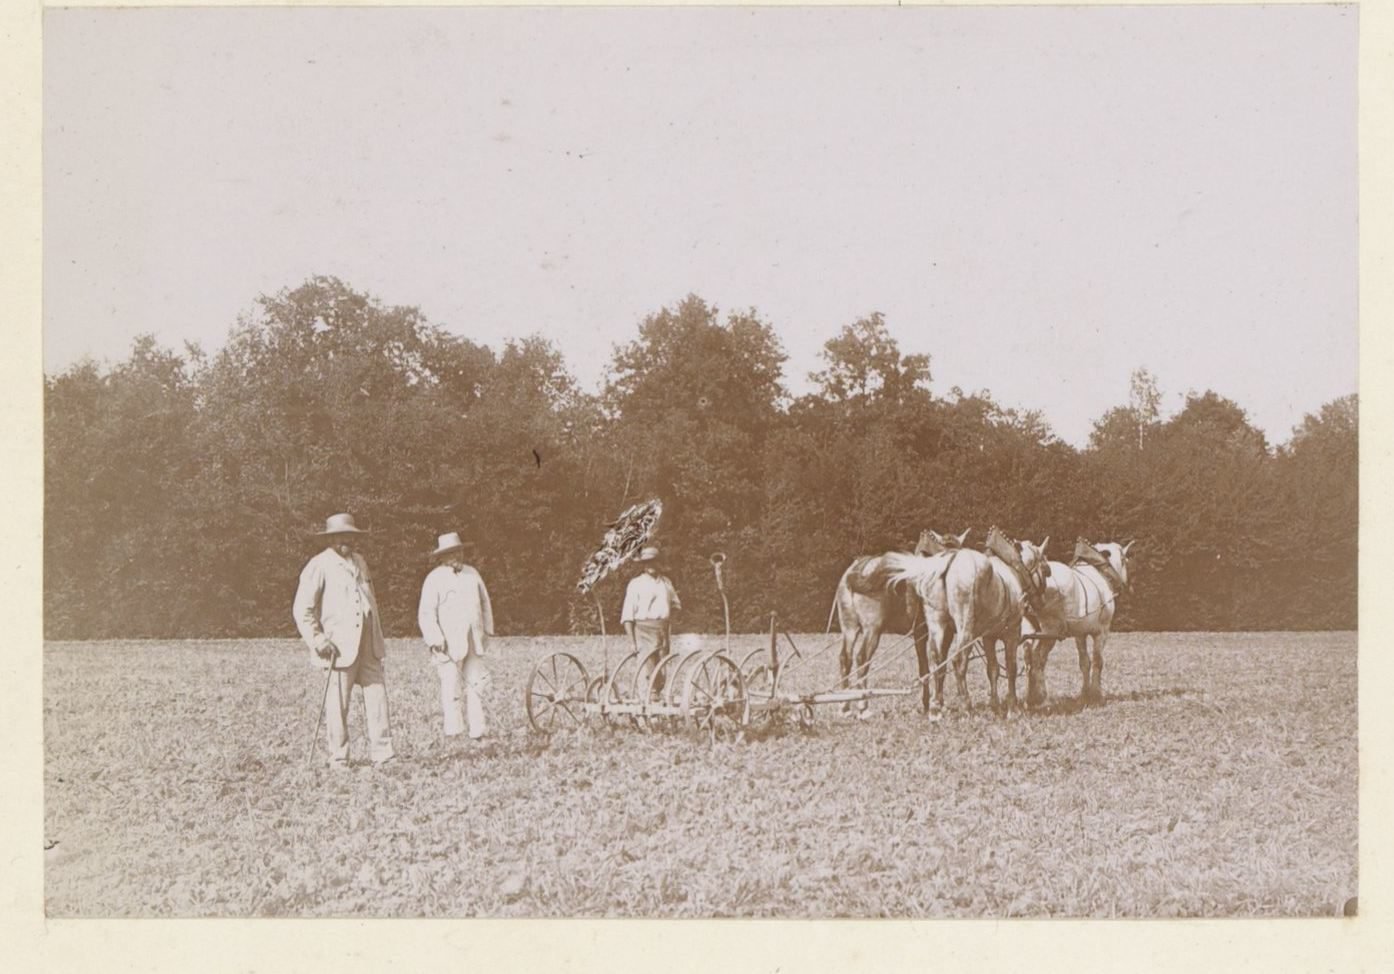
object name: photograph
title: Drie mannen bij een ploeg met een span paarden op een akker in Frankrijk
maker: Anonymous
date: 1900-1910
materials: paper, photographic support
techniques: daylight paper print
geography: france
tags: horse, agricultural implements: plough, ploughing, france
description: Onderdeel van Fotoalbum van een Franse amateurfotograaf met opnames van een familie, distilleerderij Delizy & Doistau Fils, het leger en bezienswaardigheden in Frankrijk.